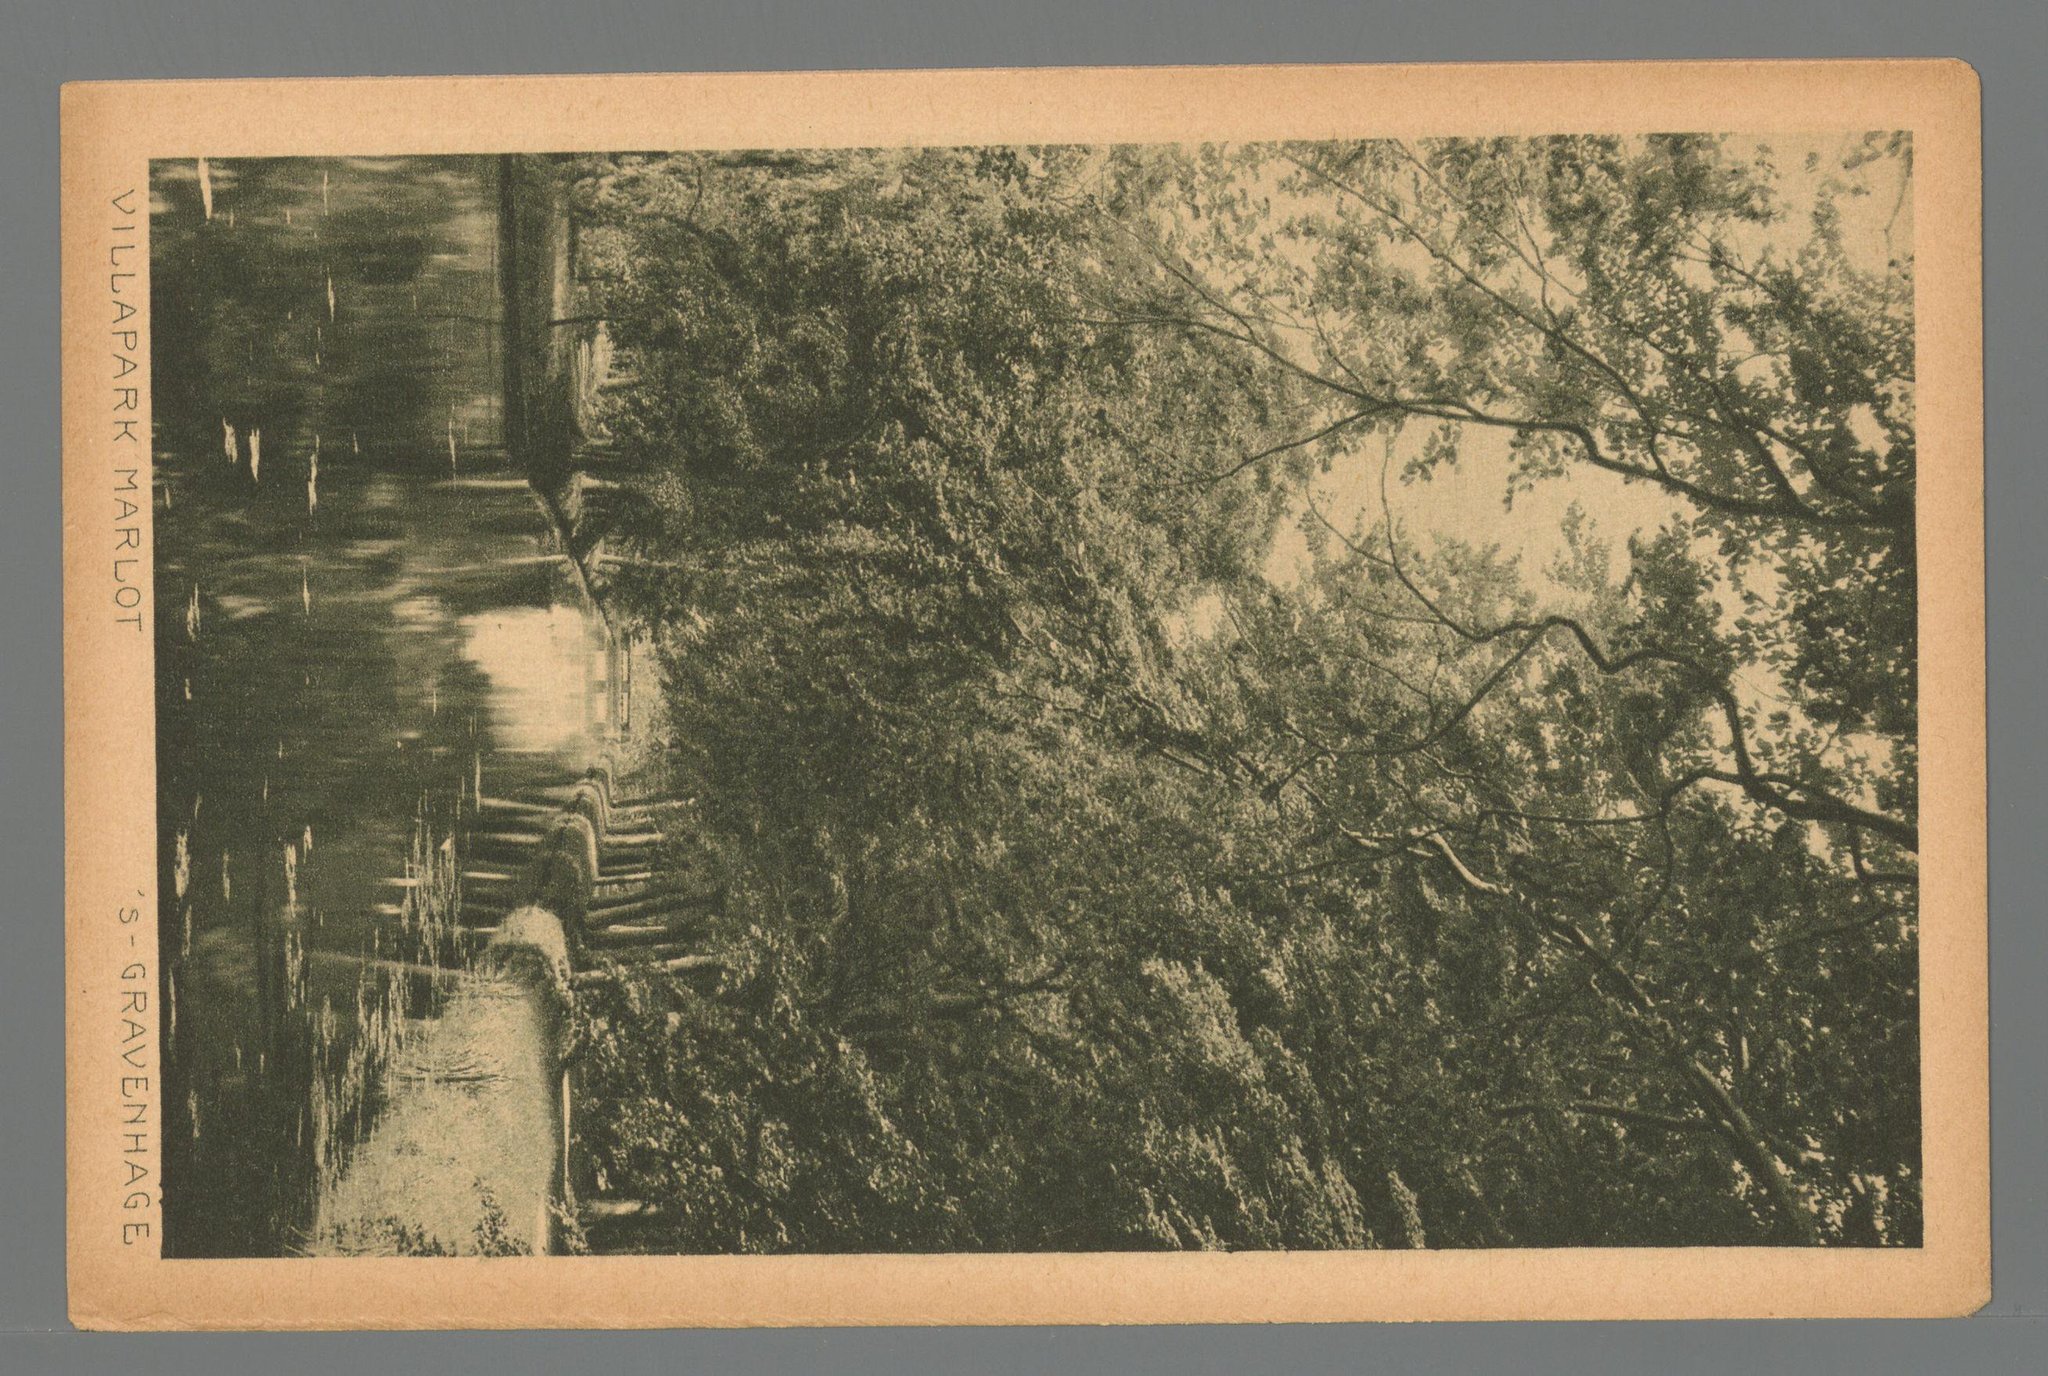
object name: photomechanical print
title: Villapark Marlot. 's-Gravenhage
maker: johannes gerardus happel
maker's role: publisher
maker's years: 1854-1928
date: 1913-1928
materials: cardboard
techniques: rotogravure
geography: the hague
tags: trees, small canal, ditch